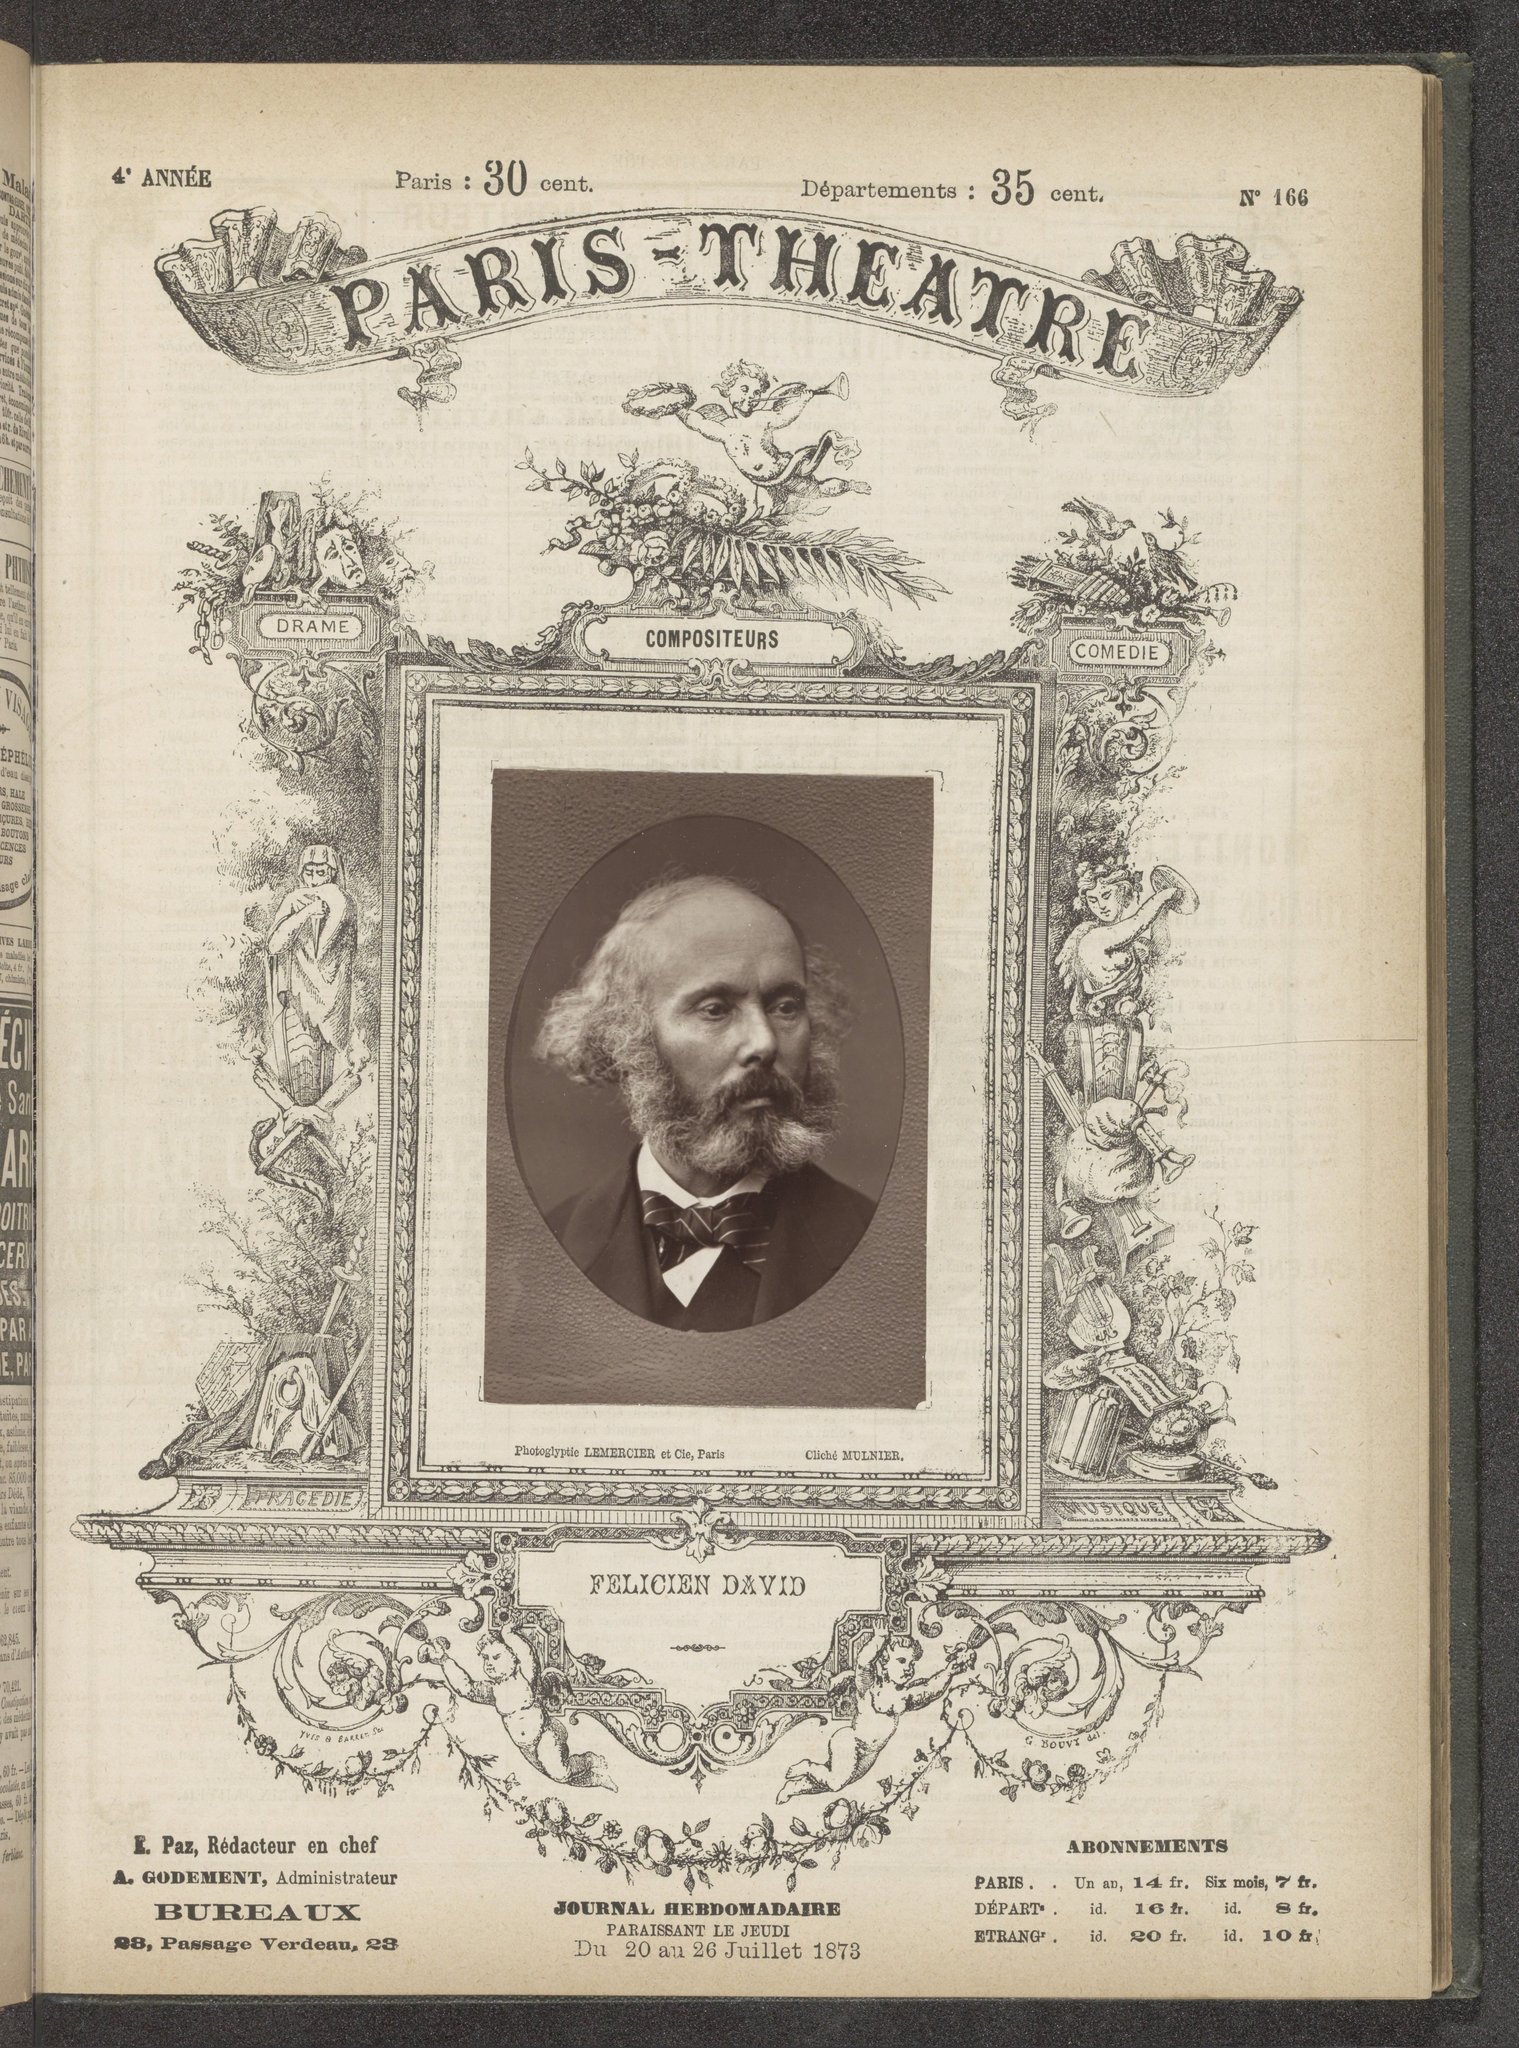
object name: page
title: Felicien David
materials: paper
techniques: woodburytype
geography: france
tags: composer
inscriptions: inscription: ‘Journal hebdomadaire paraissant le jeudi Du 20 au 26 Juillet 1876’, number: ‘No 166’